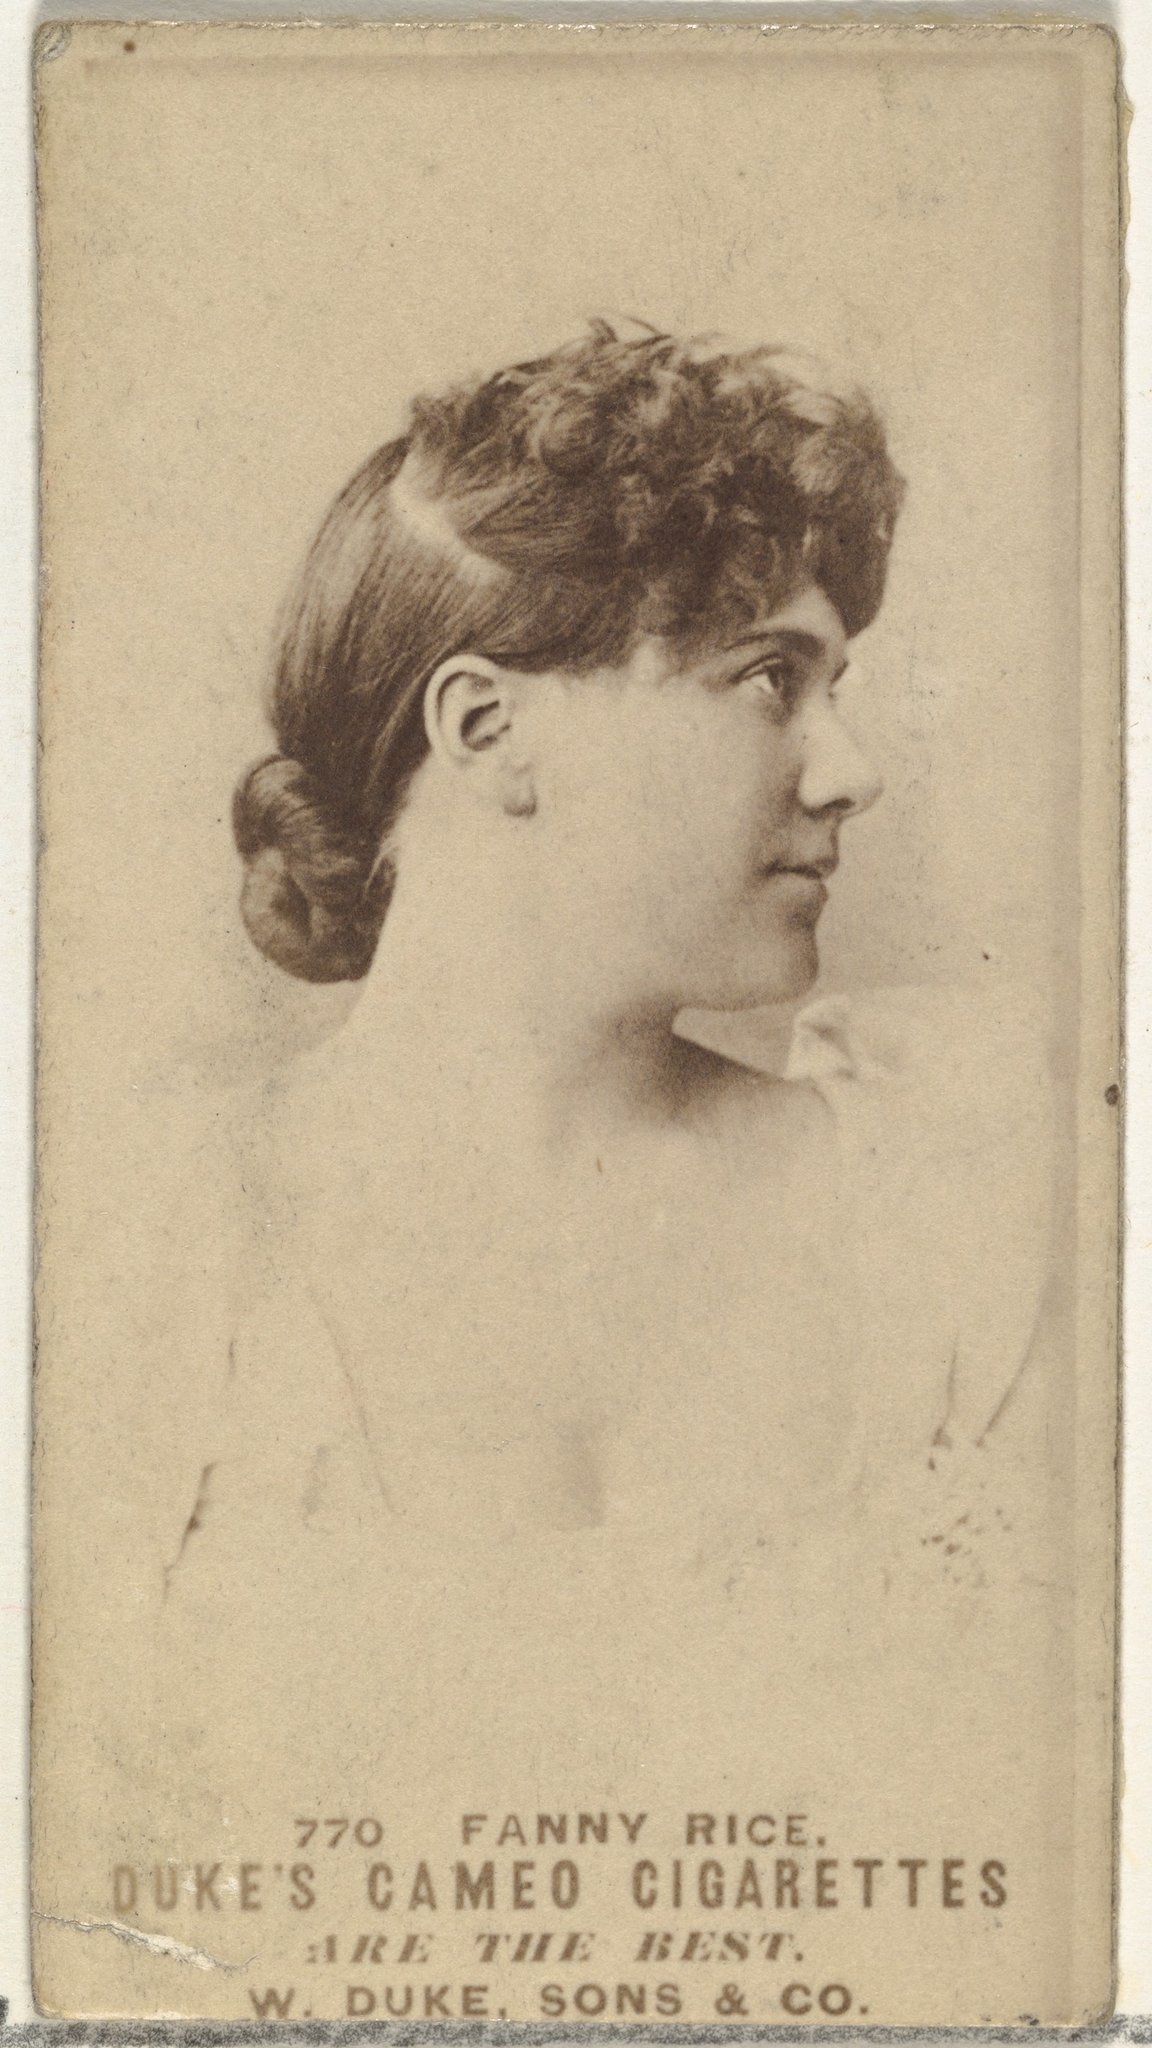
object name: photograph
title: Card Number 770, Fanny Rice, from the Actors and Actresses series (N145-5) issued by Duke Sons & Co. to promote Cameo Cigarettes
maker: w. duke, sons & co.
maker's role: publisher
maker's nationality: american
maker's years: 1870-1920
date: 1880-1889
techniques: albumen silver print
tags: women,actresses